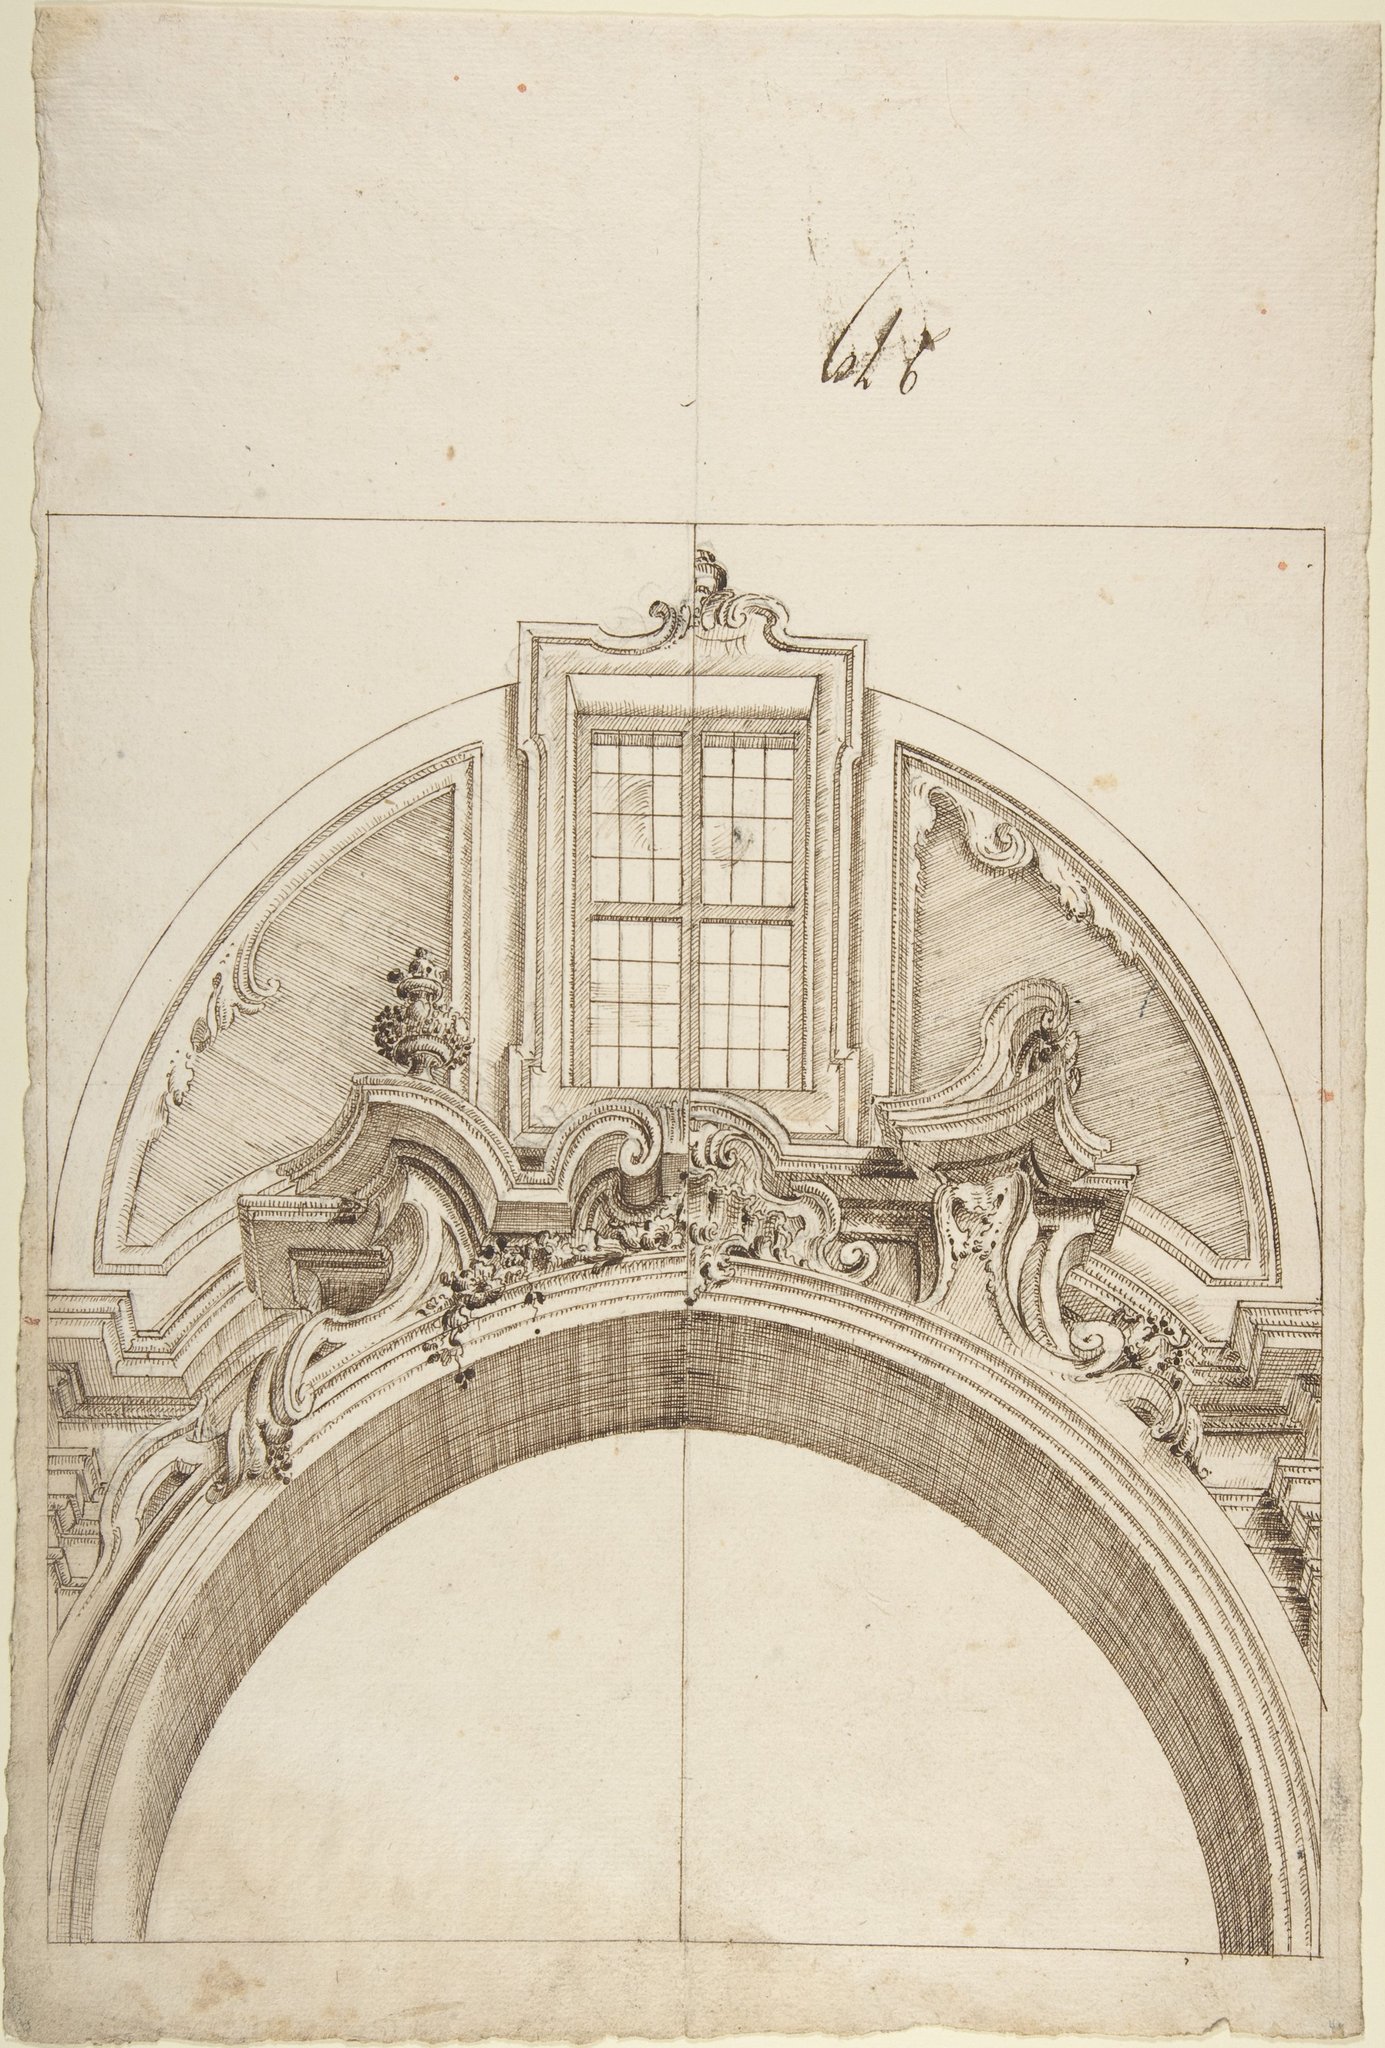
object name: drawing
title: Two alternate designs for an arch below a window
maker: anonymous, italian, piedmontese, 18th century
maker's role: artist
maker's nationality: italian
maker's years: 1700-1800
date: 1700-1780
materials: graphite, ink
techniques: pen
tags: architecture,arches,windows